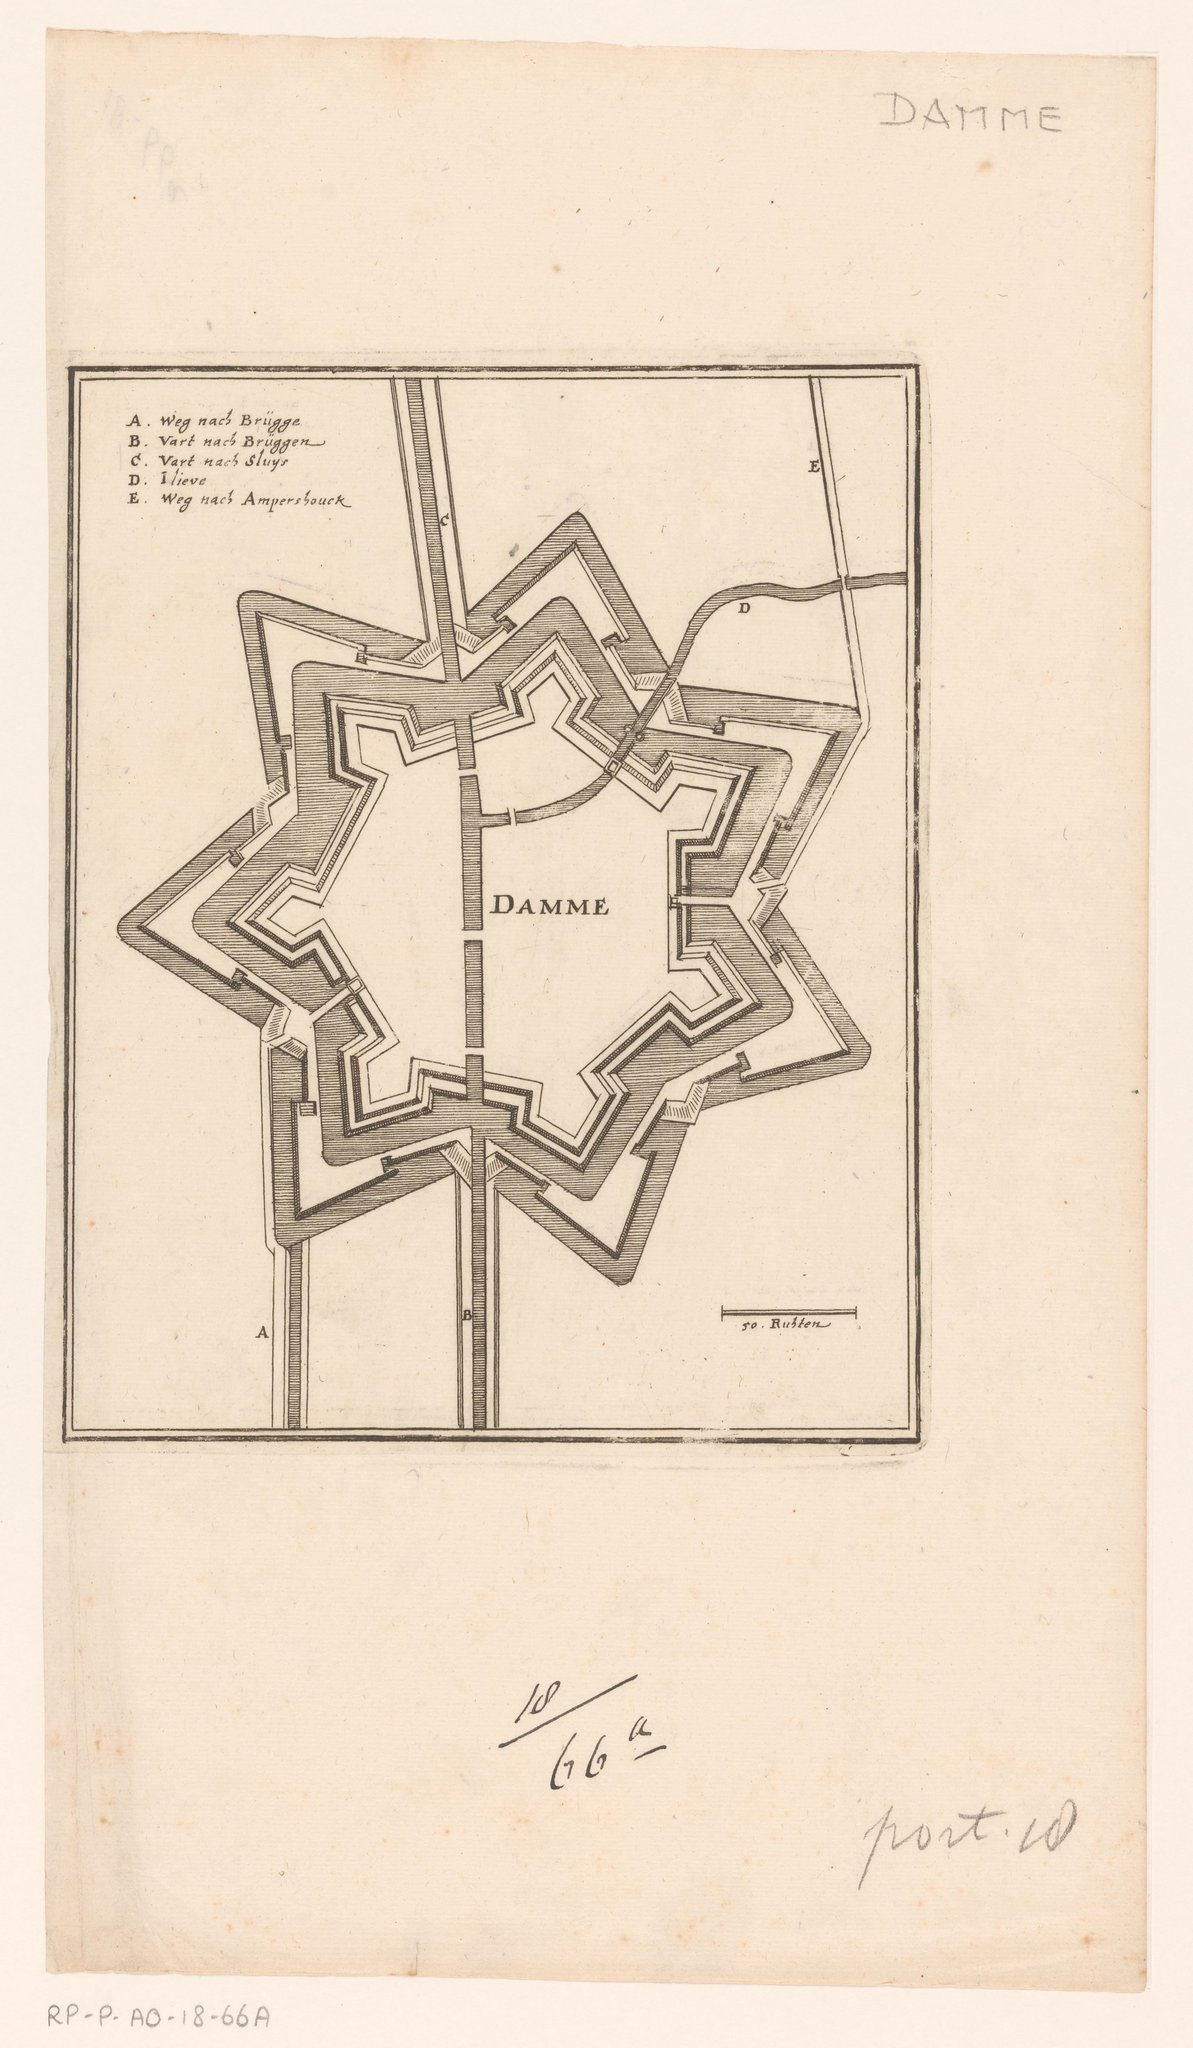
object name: print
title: Damme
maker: caspar merian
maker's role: print maker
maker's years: 1627-1689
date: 1654-1700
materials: paper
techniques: etching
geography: frankfurt am main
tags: fortified city, maps of cities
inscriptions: collector's mark: Lugt 2228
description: Prent gebruikt in: Zeiller, Martin. M.Z. Topographia Circuli Burgundici Oder Beschreibung une Eigentliche Abbildung der Vornehmsten Örter in dem Hochlöblichen Burgund- un Niderlandischen Crayse. Frankfurt am Main: Caspar Merian, 1654. Of in: Zeiller, Martin. M. Z. Topographia Germaniae-Inferioris vel Circuli-Burgundici, das ist Beschreibung (…). Frankfurt am Main: Caspar Merian, 1659. Of in een van de twee latere uitgaven van deze publicatie die, hoewel het jaar 1659 erin staat vermeld als jaar van uitgave, zijn uitgegeven in respectievelijk ca. 1670 en ca. 1700.